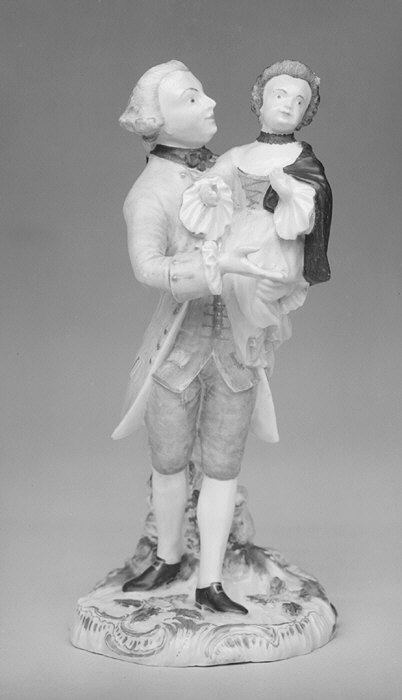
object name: figure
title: The Ventriloquist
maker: hesse-cassel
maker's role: factory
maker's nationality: german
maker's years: 1766-1788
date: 1770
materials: hard paste porcelain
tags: men,dolls